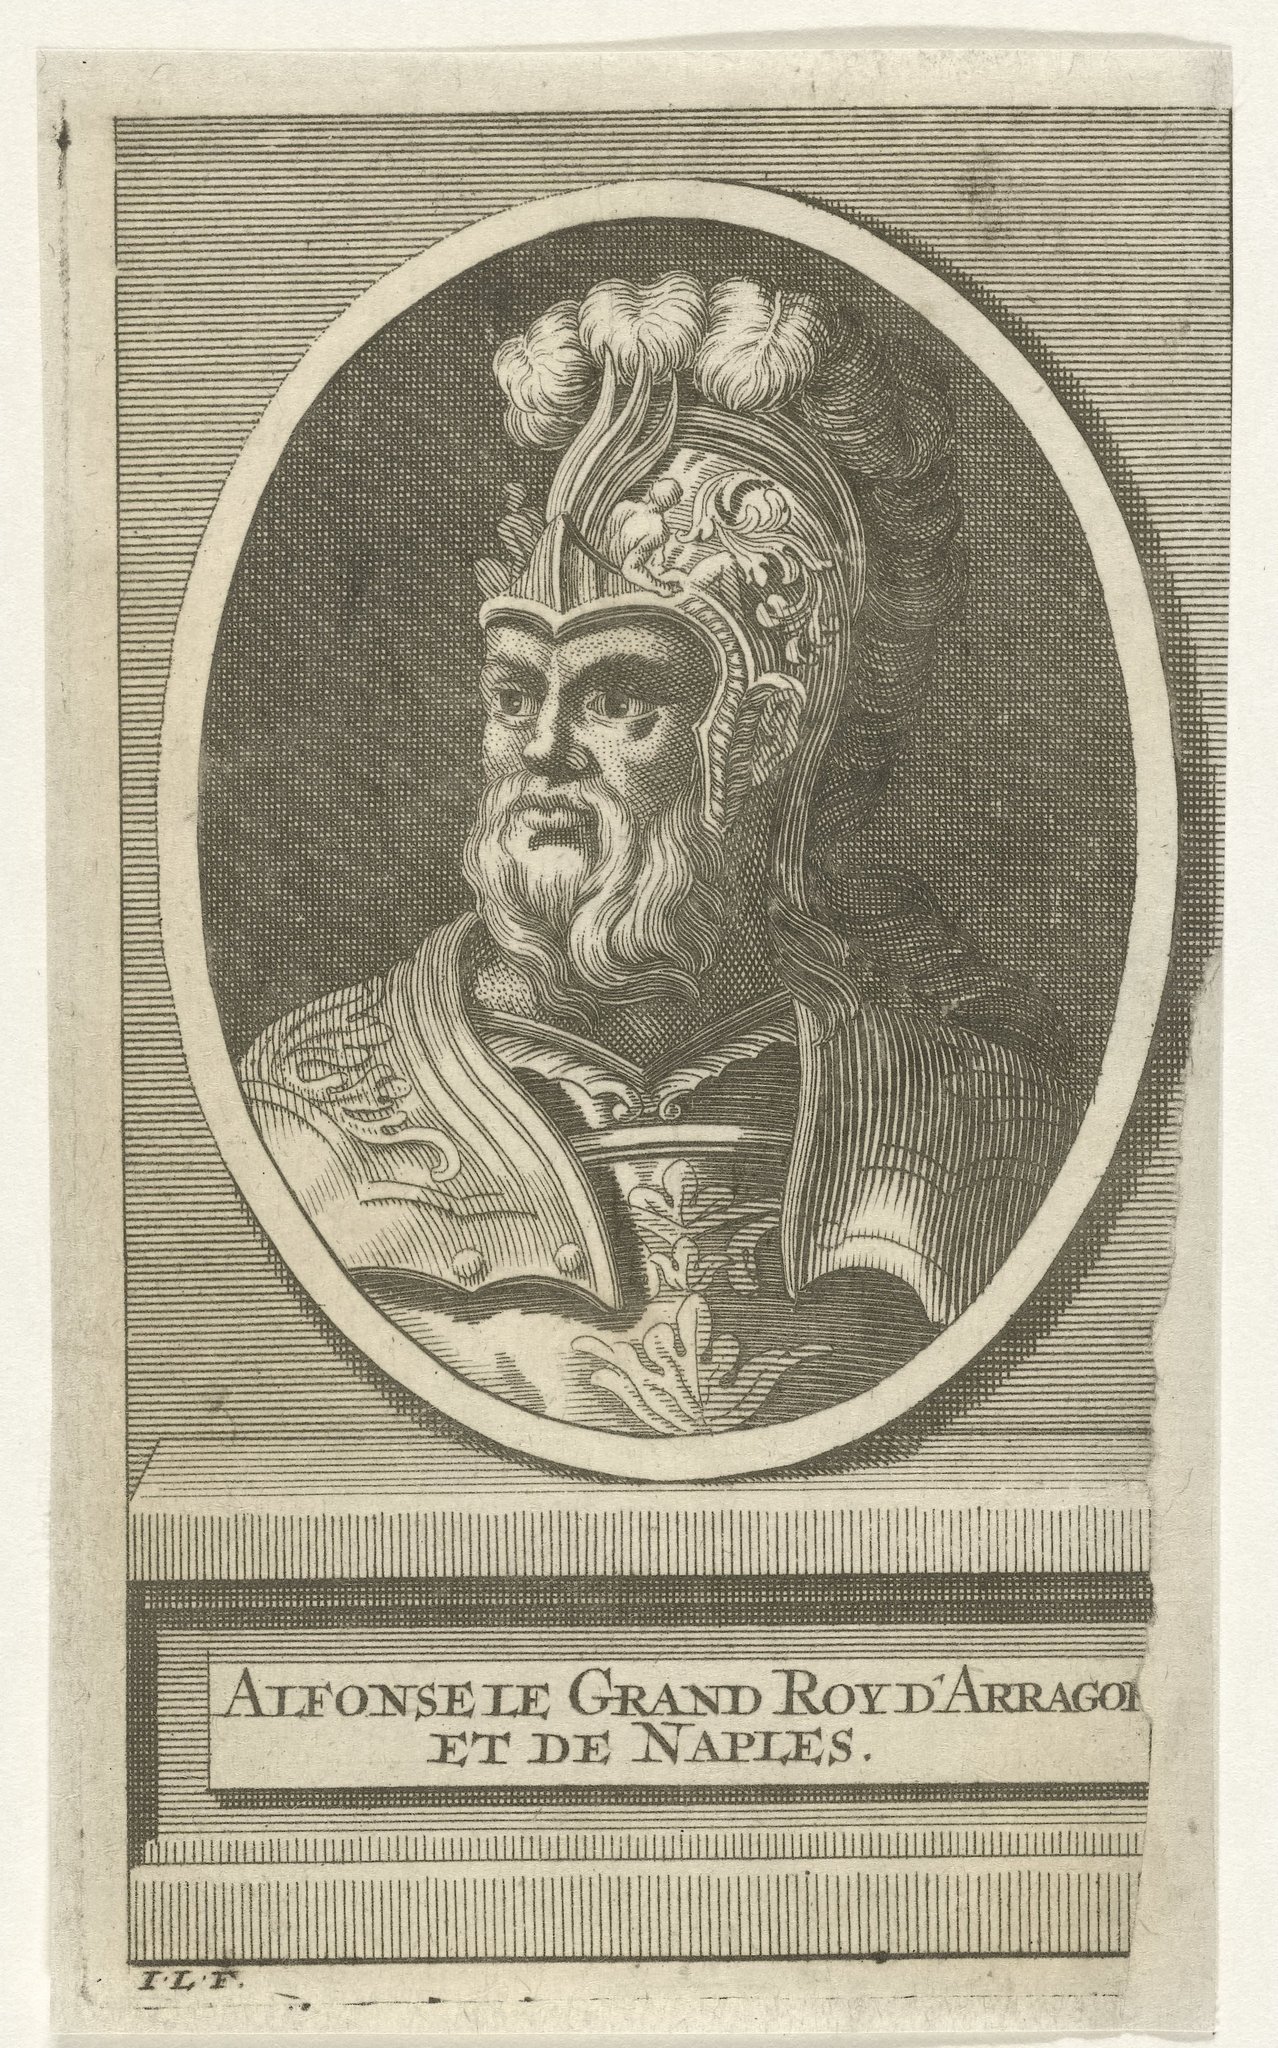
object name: print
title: Portret van Alfonso V de Grootmoedige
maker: jan lamsvelt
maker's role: print maker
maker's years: 1674-1743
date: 1684-1743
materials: paper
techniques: engraving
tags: naples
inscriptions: collector's mark: Lugt 2228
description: Portretbuste in ovaal naar rechts van Alfonso V de Grootmoedige, koning van Aragon, met gepluimde helm en gehuld in een harnas. Het portret steunt op een sokkel waarop de naam van de geportretteerde staat.